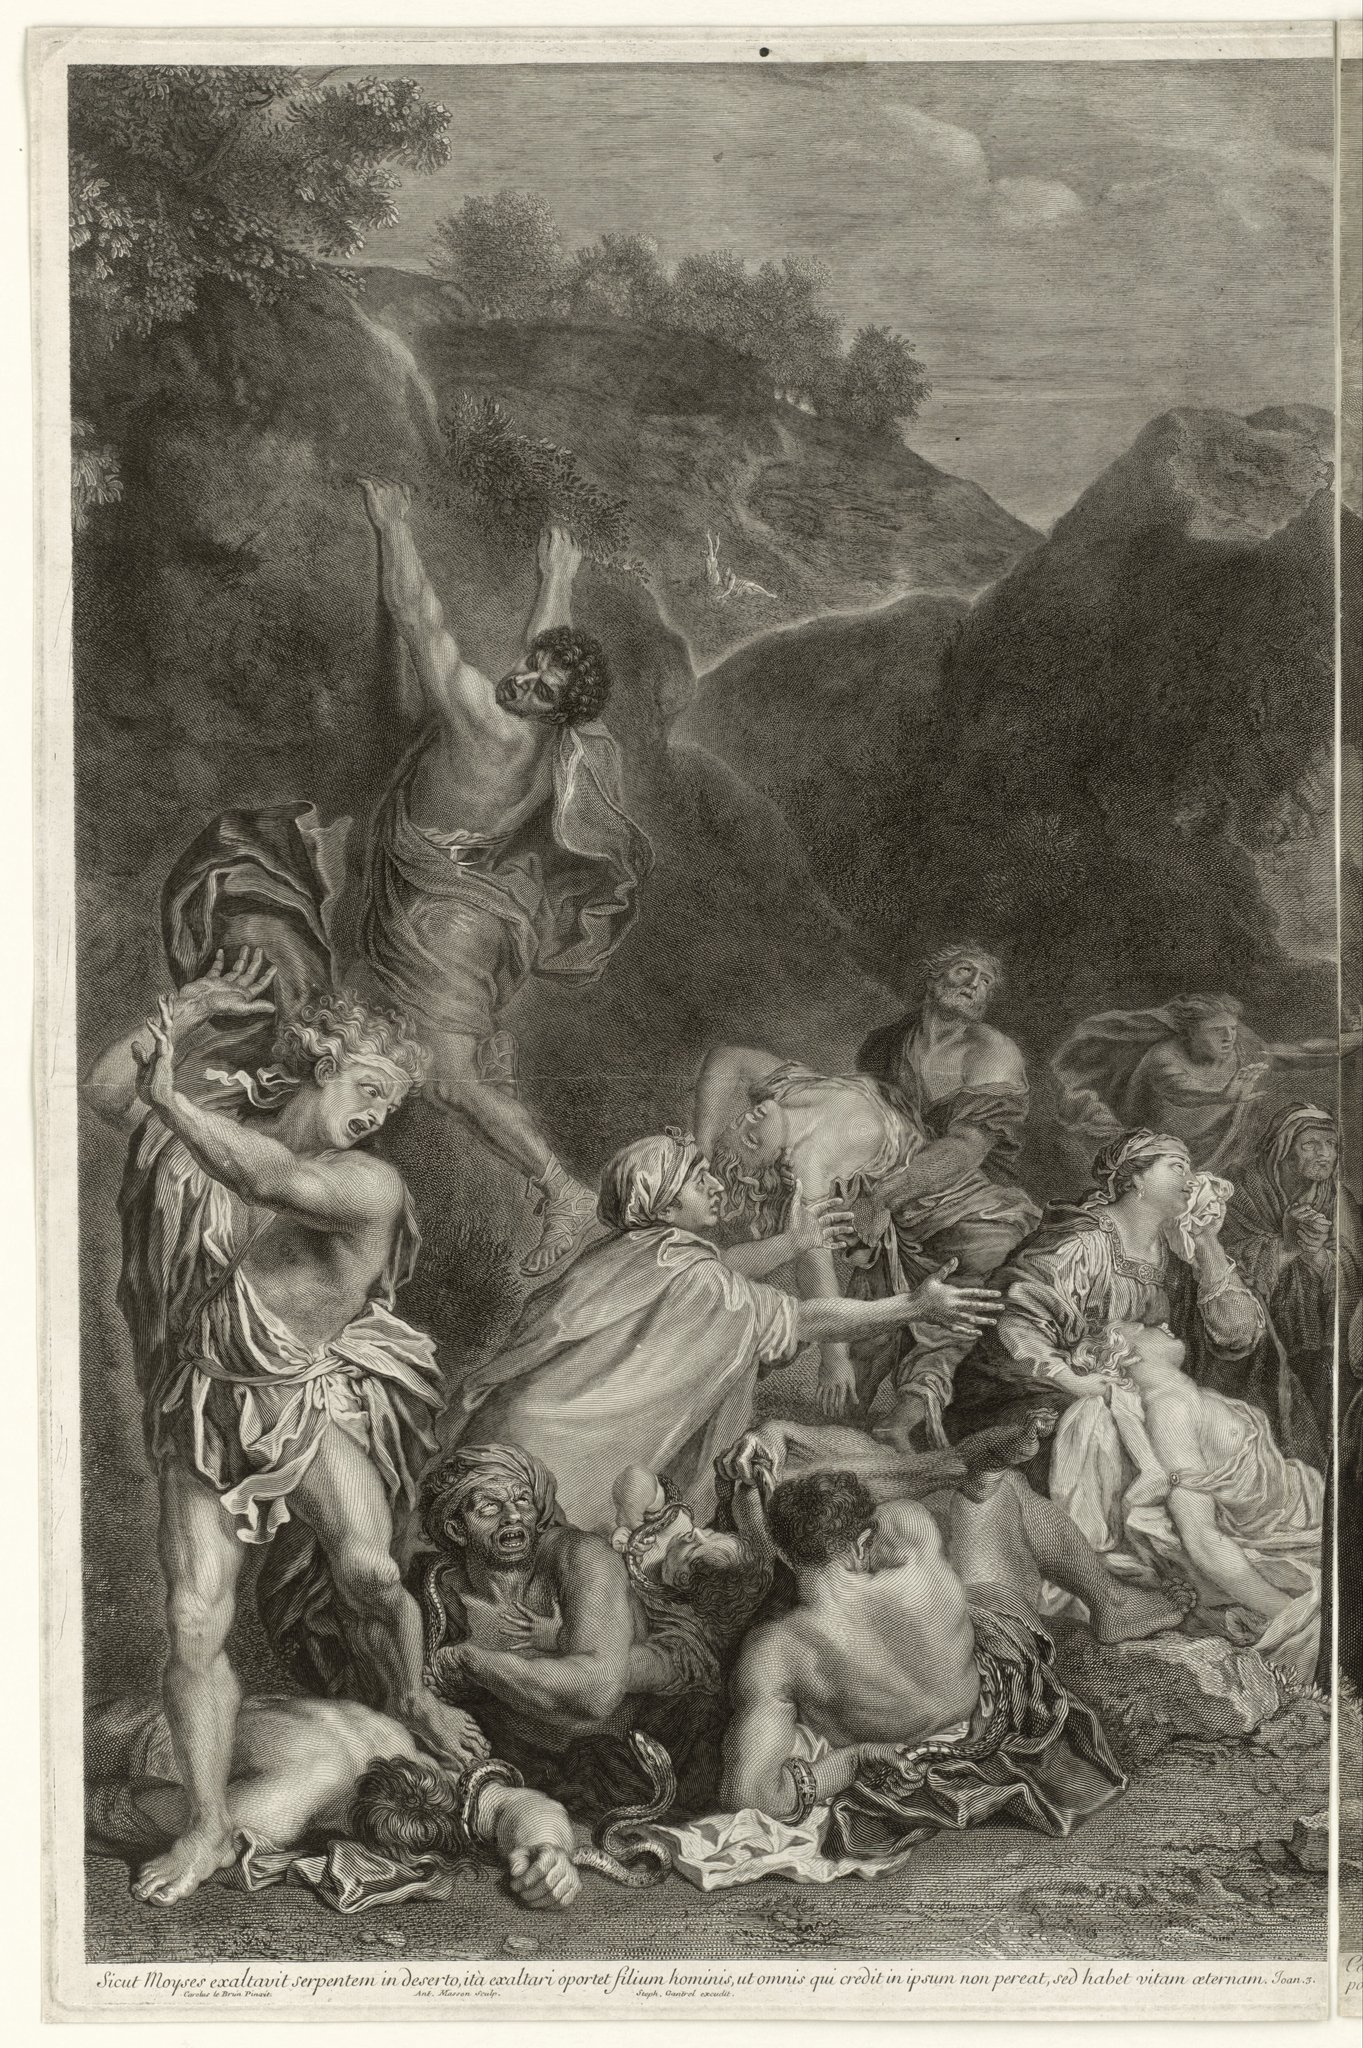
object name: print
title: De oprichting van de koperen slang (linker helft)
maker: antoine masson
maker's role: print maker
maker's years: 1636-1700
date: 1646-1700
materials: paper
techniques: engraving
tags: the brazen serpent (numbers 21:4-9)